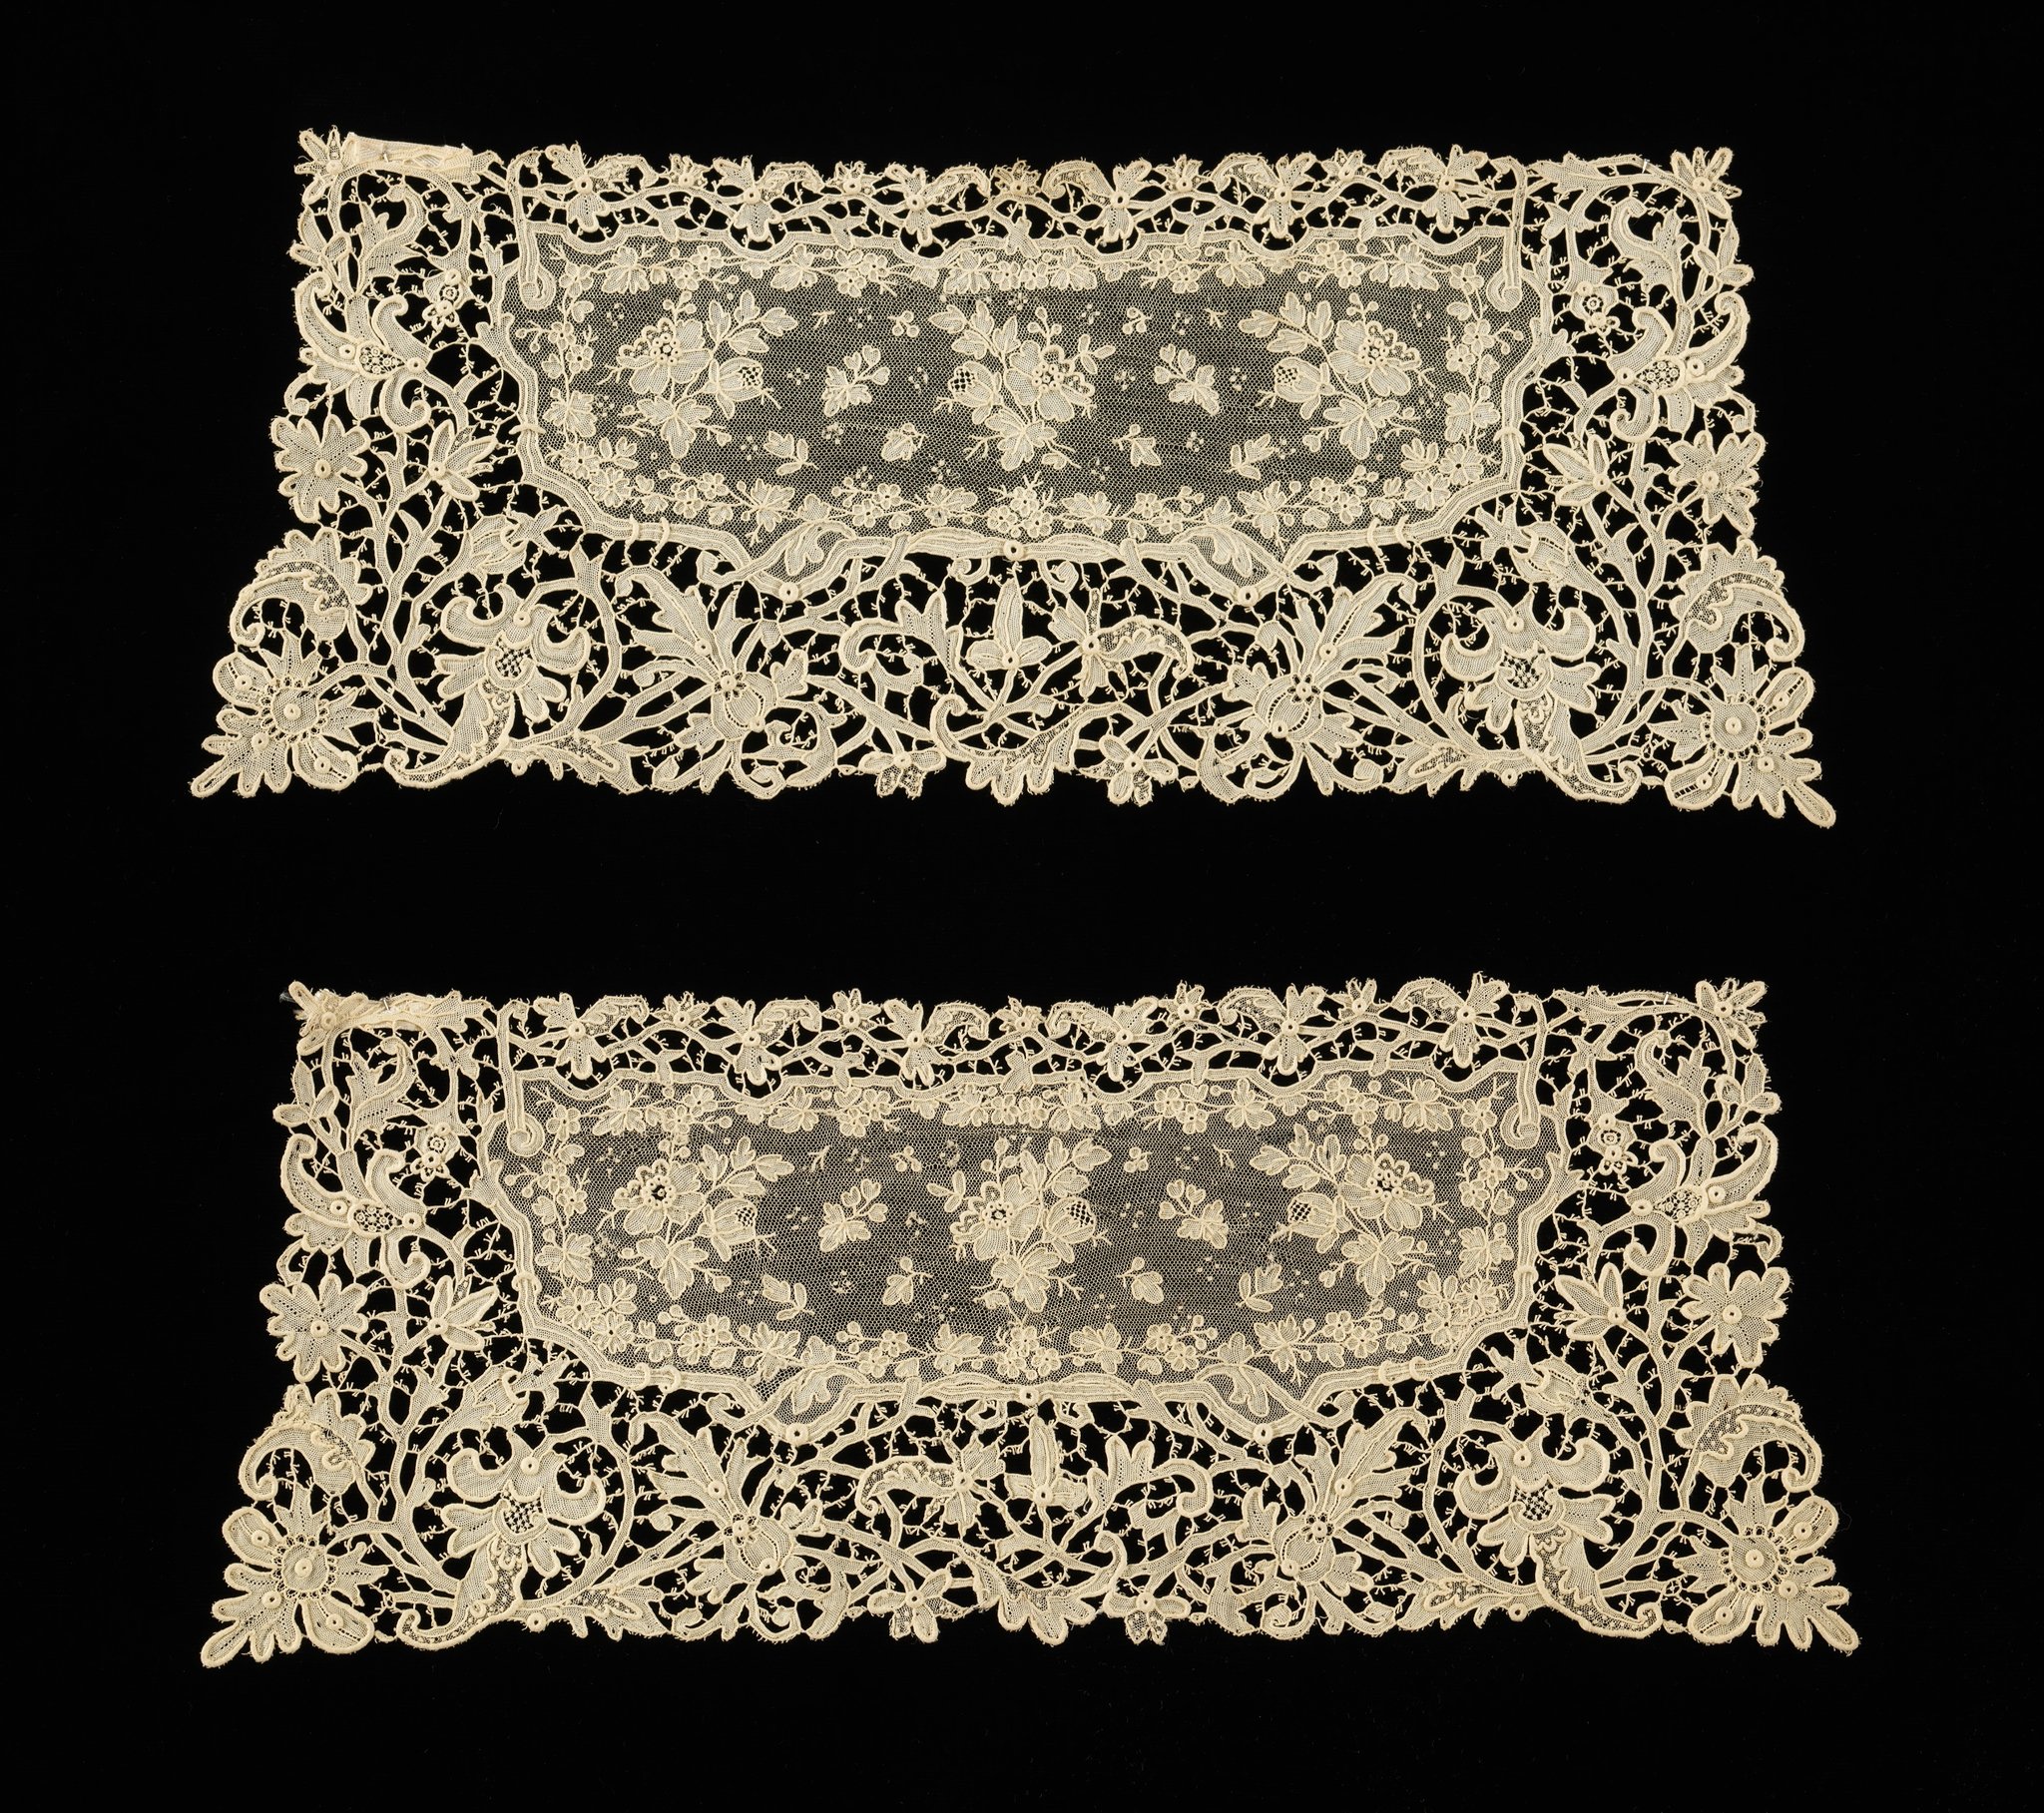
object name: cuff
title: Cuffs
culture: belgian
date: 1890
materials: linen